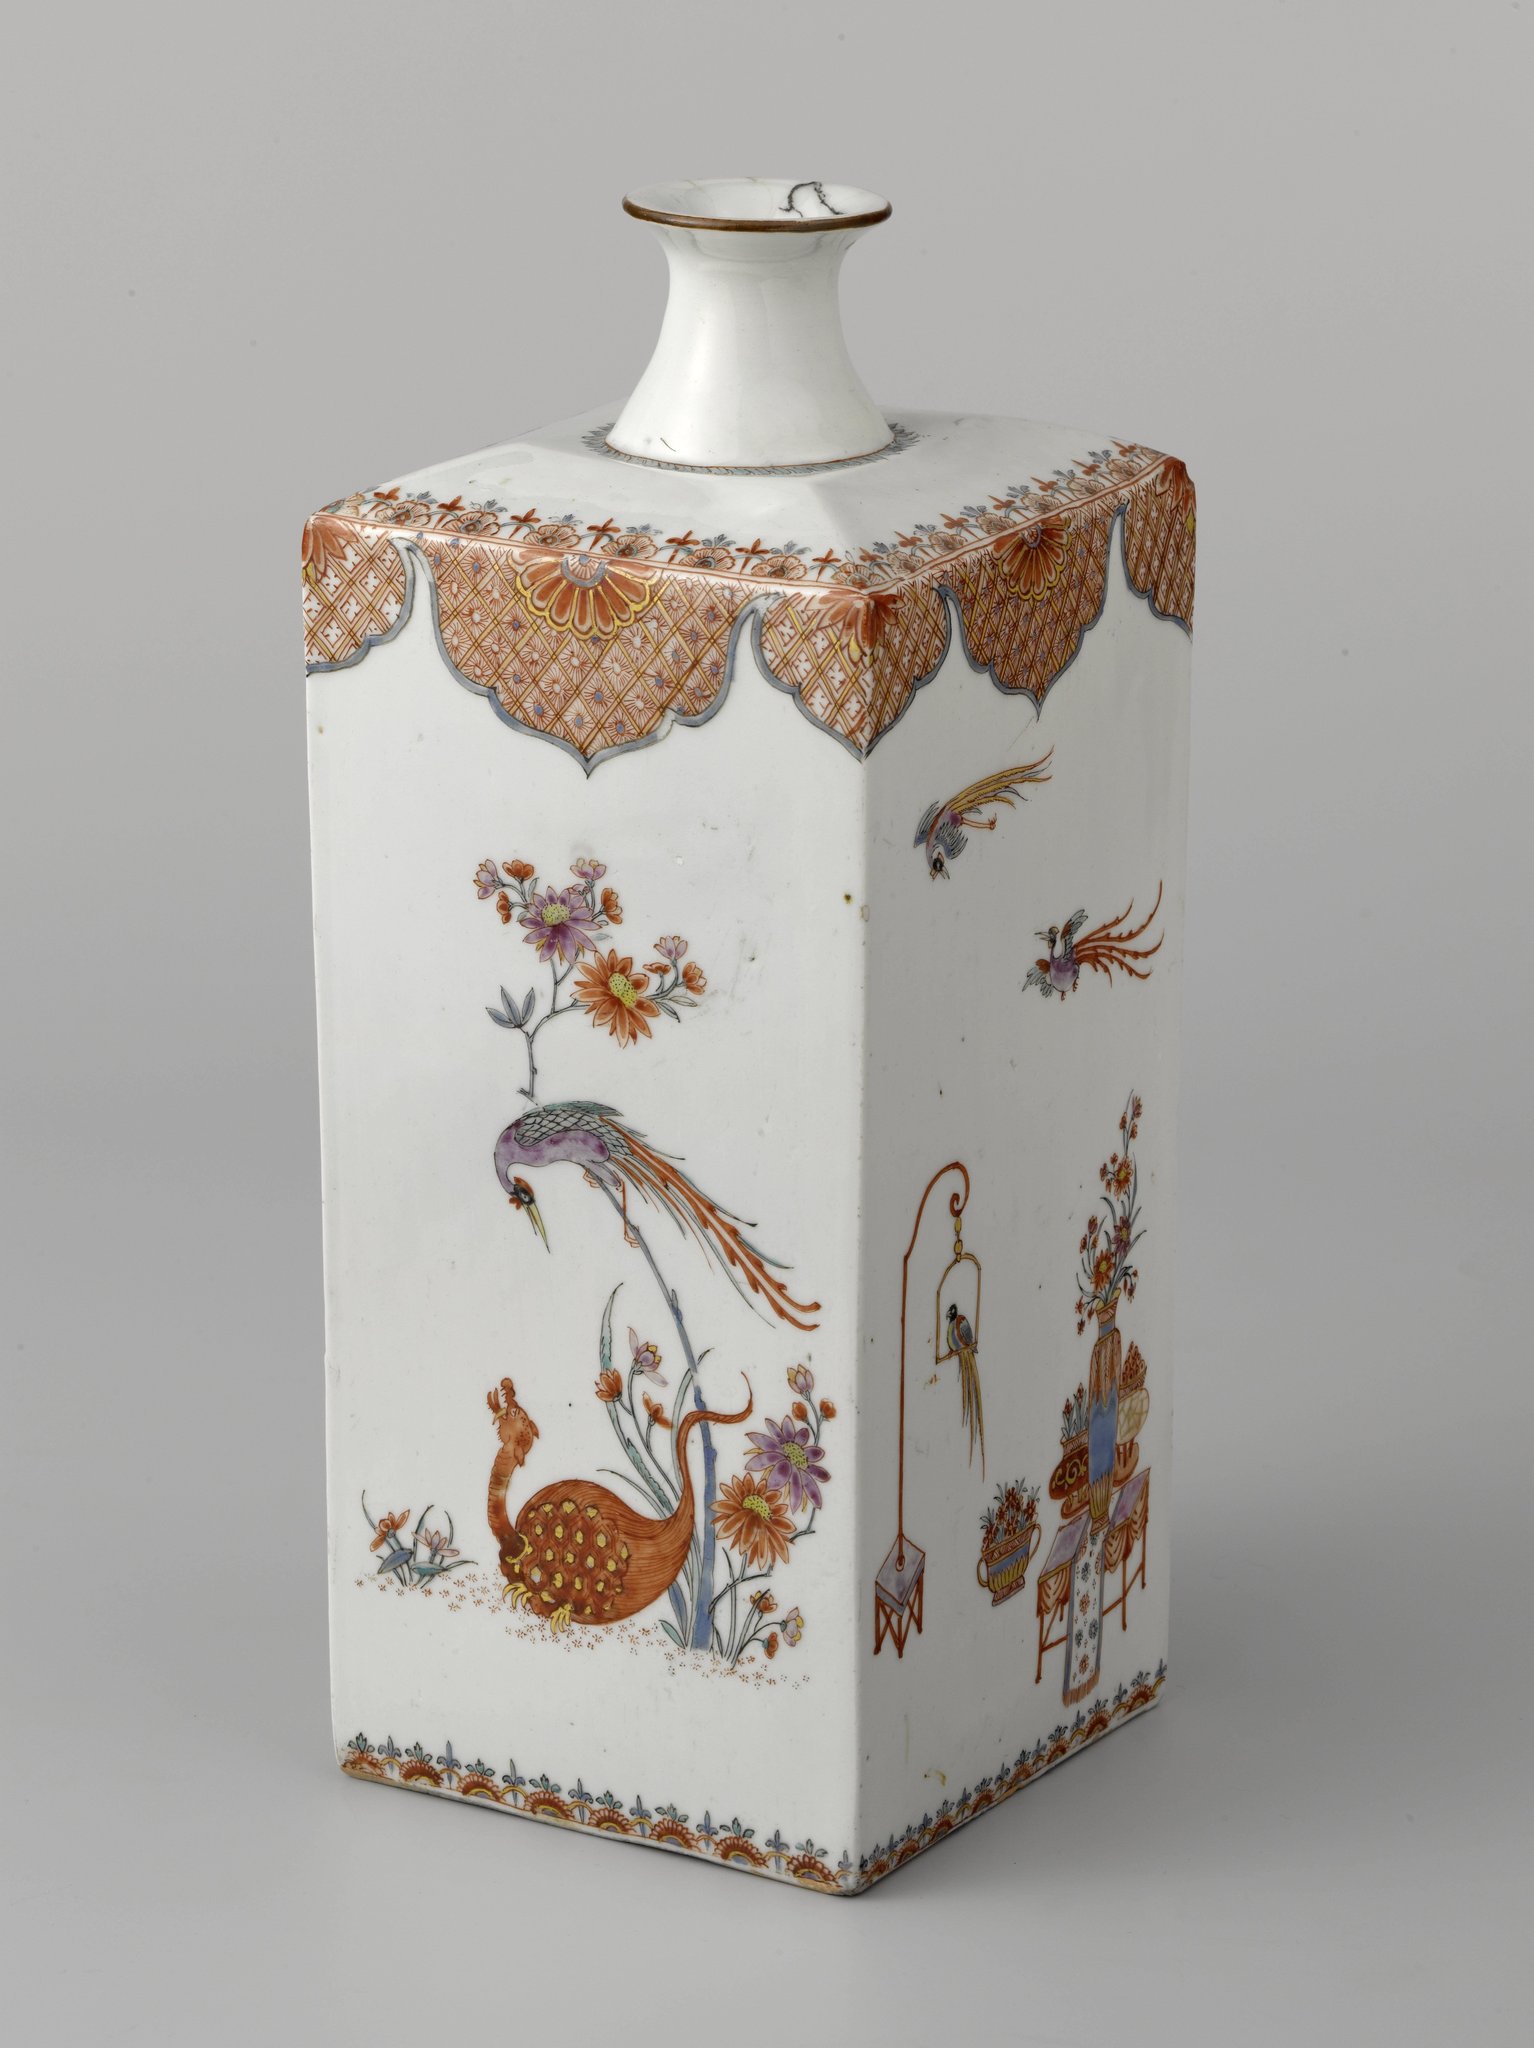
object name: bottle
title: Square bottle with flowering plants, a dragon, birds, flower vases and insects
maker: Anonymous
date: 1700-1724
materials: glaze, gold, paint, porcelain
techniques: firing, gilding, turning, vitrification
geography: arita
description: Square flask. Japan, c. 1700 - 1720, decorated, c. 1710 - 1725.